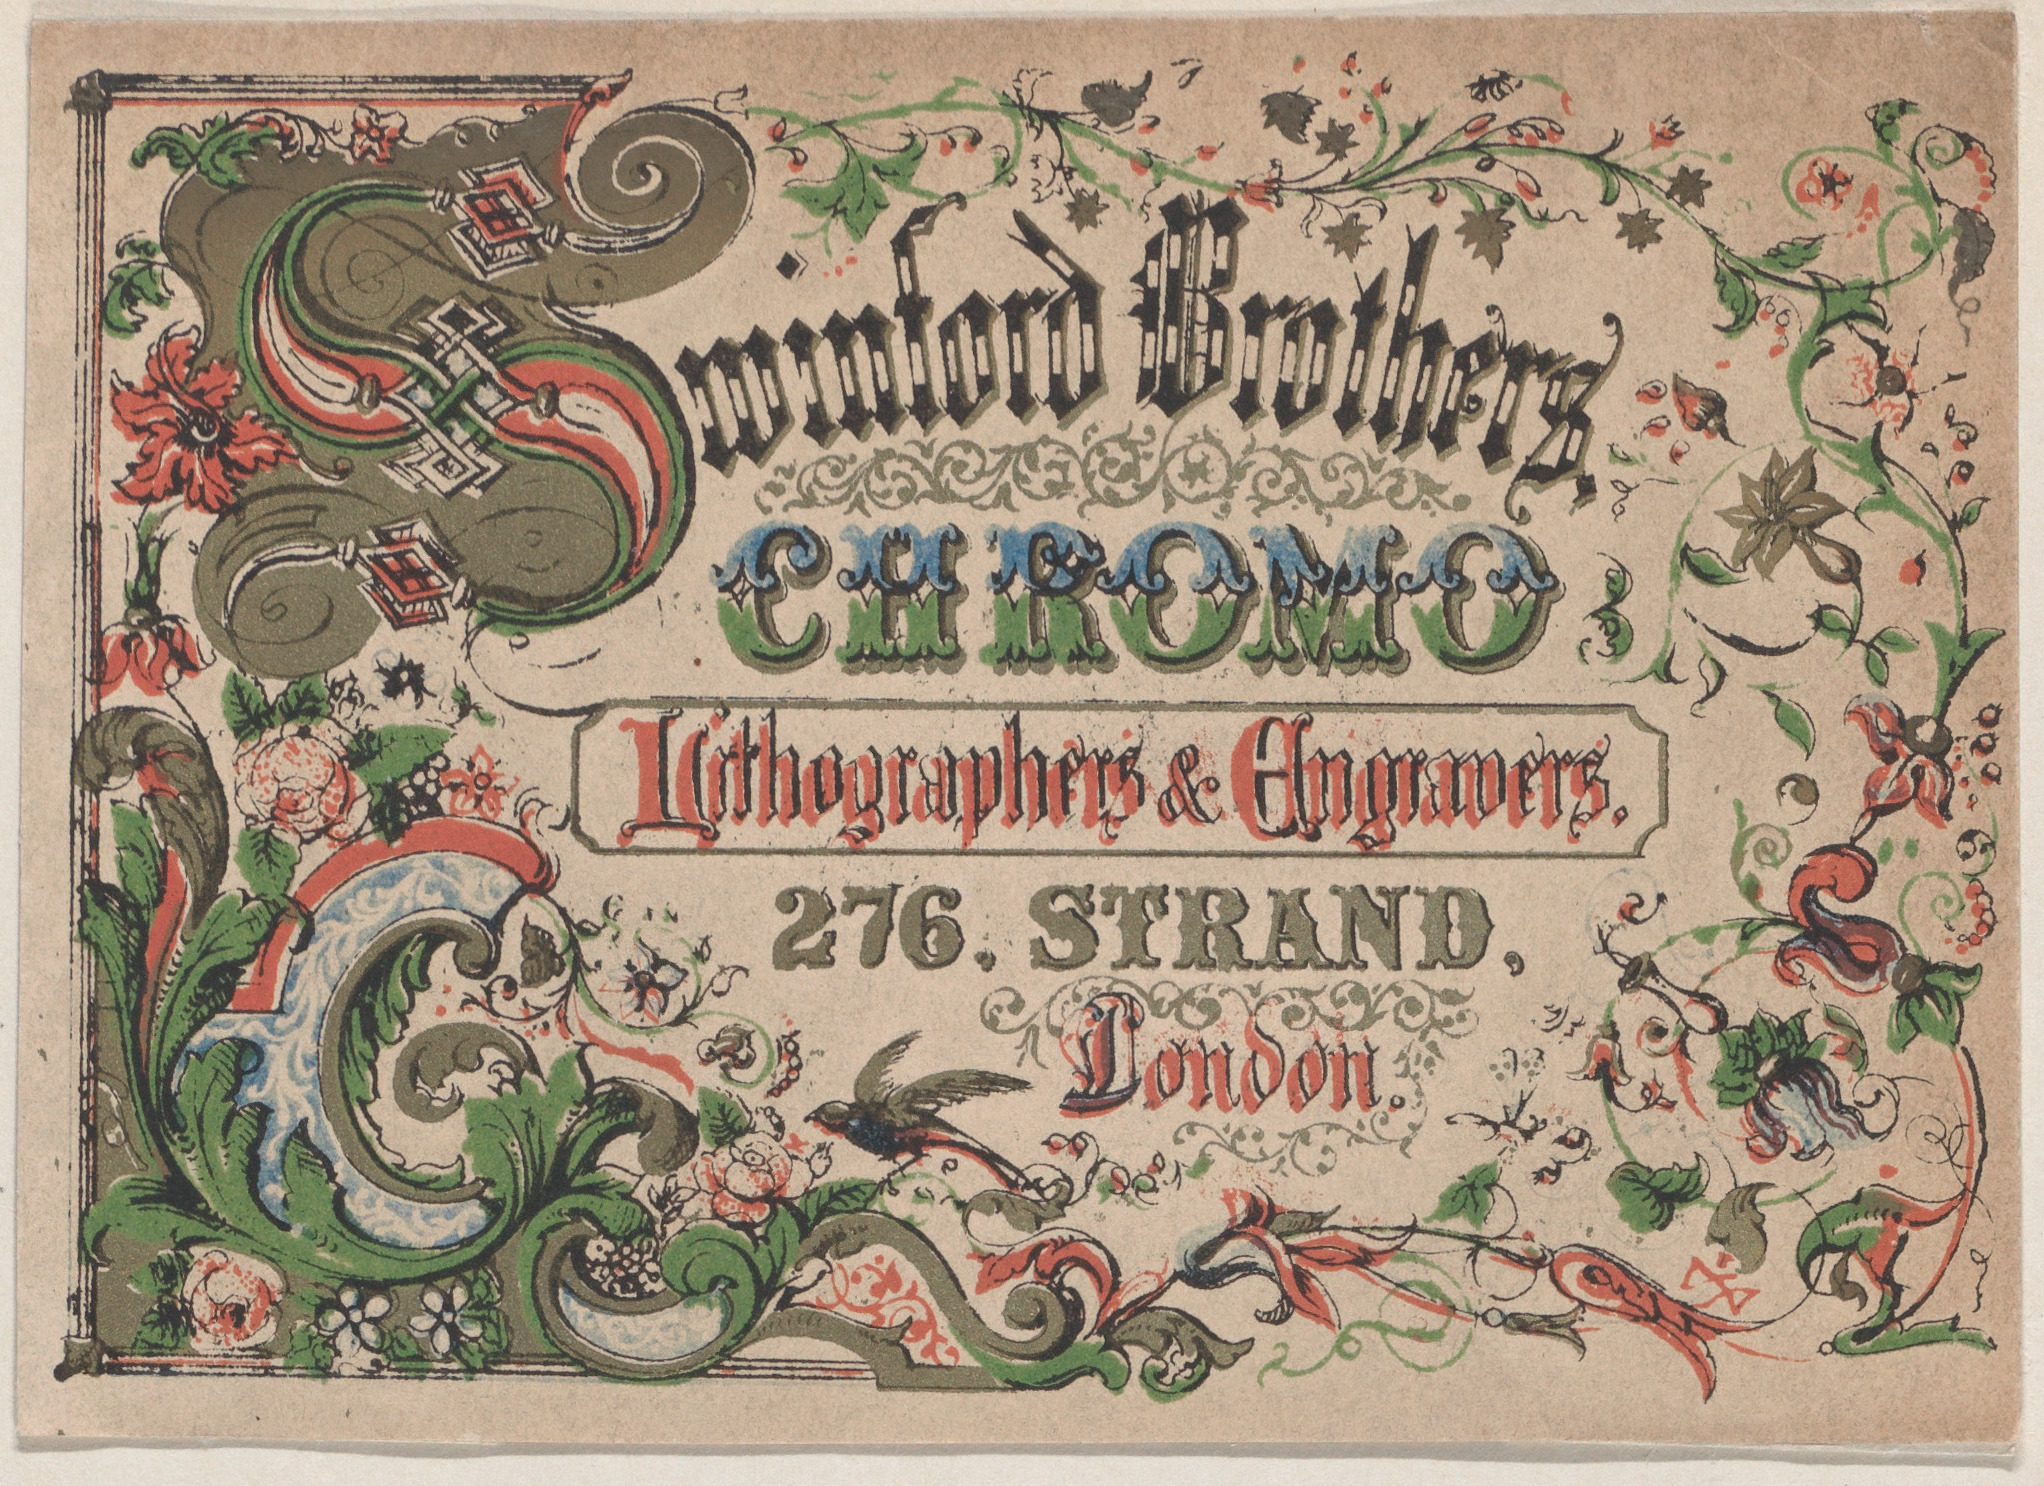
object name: print, trade card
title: Trade Card for Swinford Brothers, Chromo Lithographers & Engravers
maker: anonymous, british, 19th century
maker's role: artist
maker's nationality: british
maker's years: 1800-1900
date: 1801-1900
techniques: lithograph